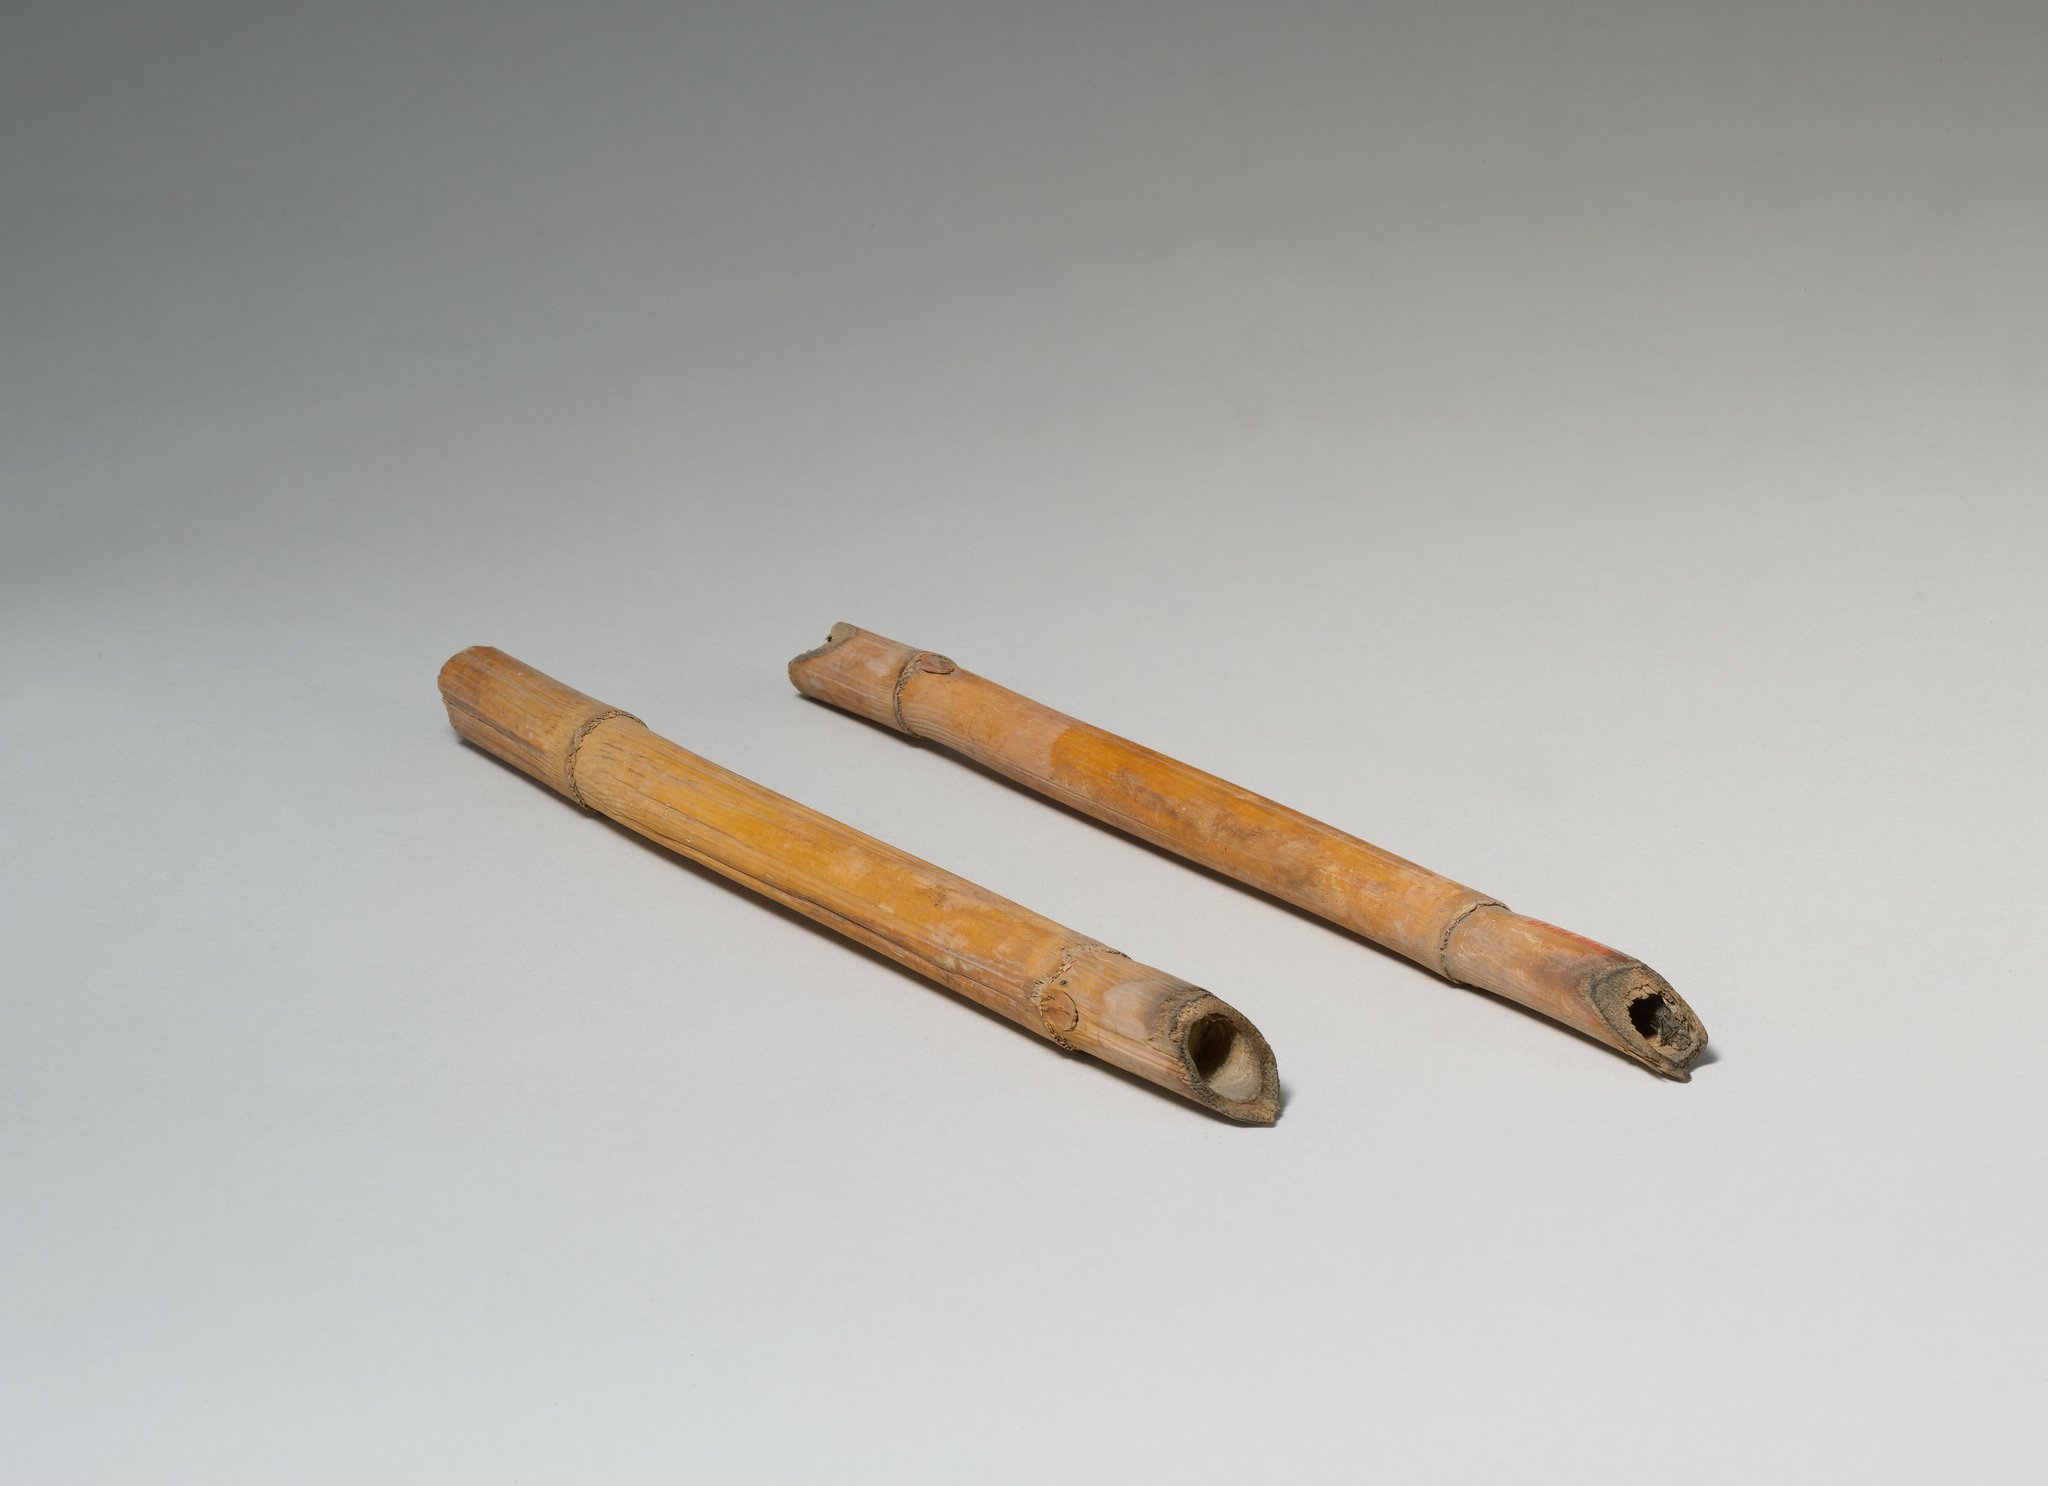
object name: embalmer's stick 2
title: Sharpened Sticks from Tutankhamun's Embalming Cache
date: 1336-1327 BCE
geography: egypt